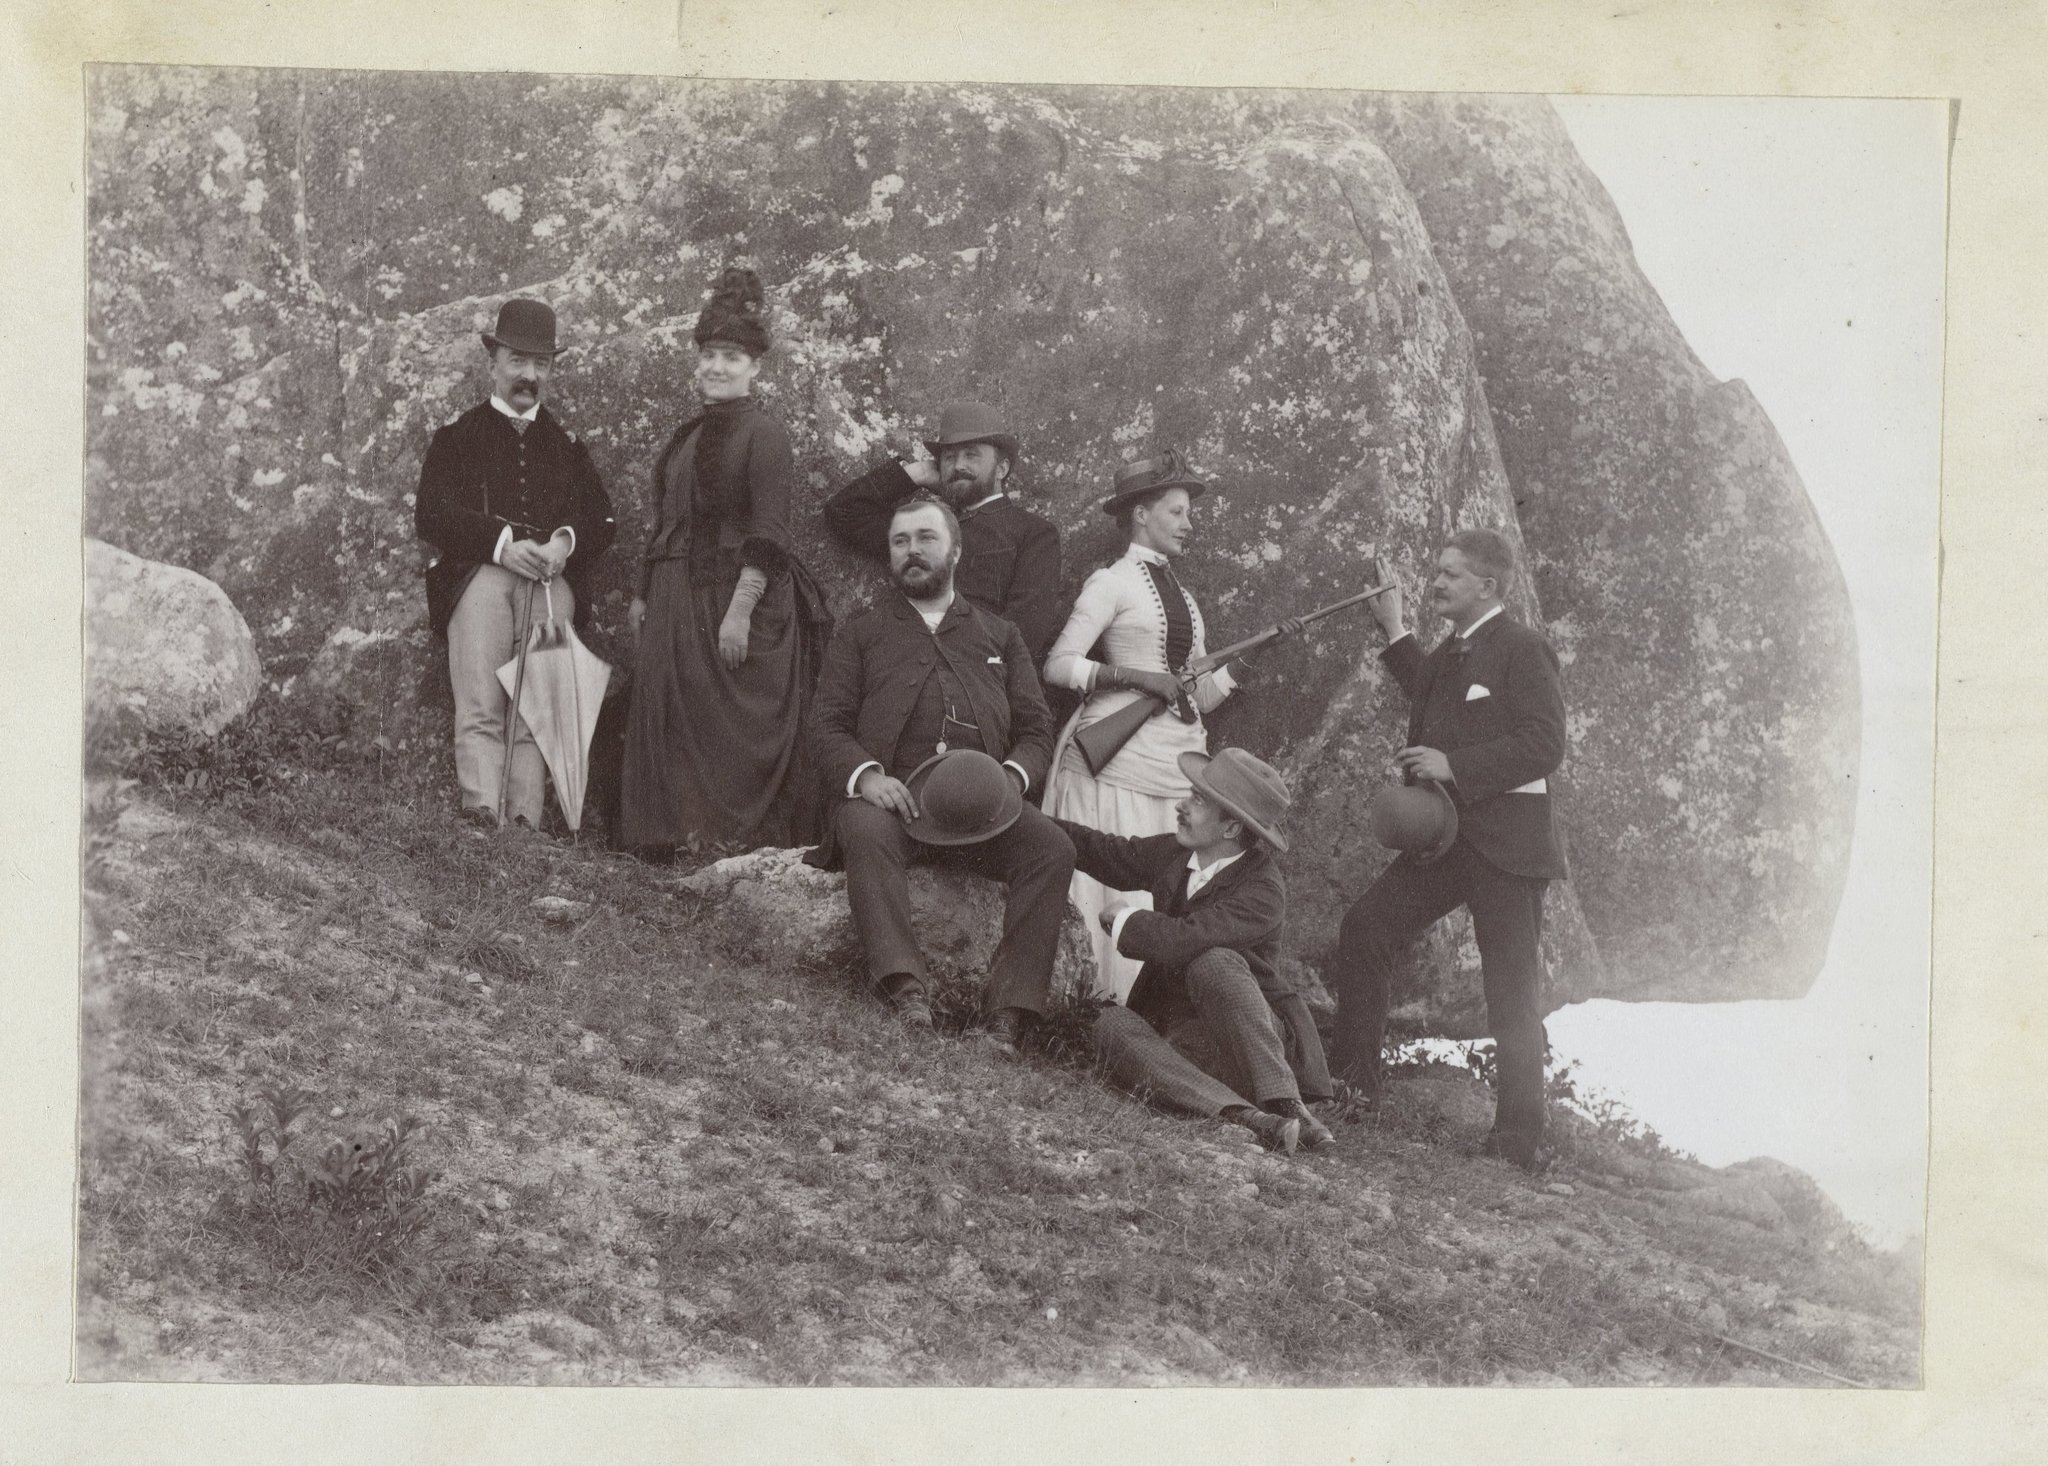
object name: photograph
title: Groepsportret van mensen bij een rots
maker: Anonymous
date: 1879-1890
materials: paper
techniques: albumen print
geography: china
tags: outdoor gathering, 'délices à la campagne', anonymous historical persons portrayed in a group, in a group-portrait, china